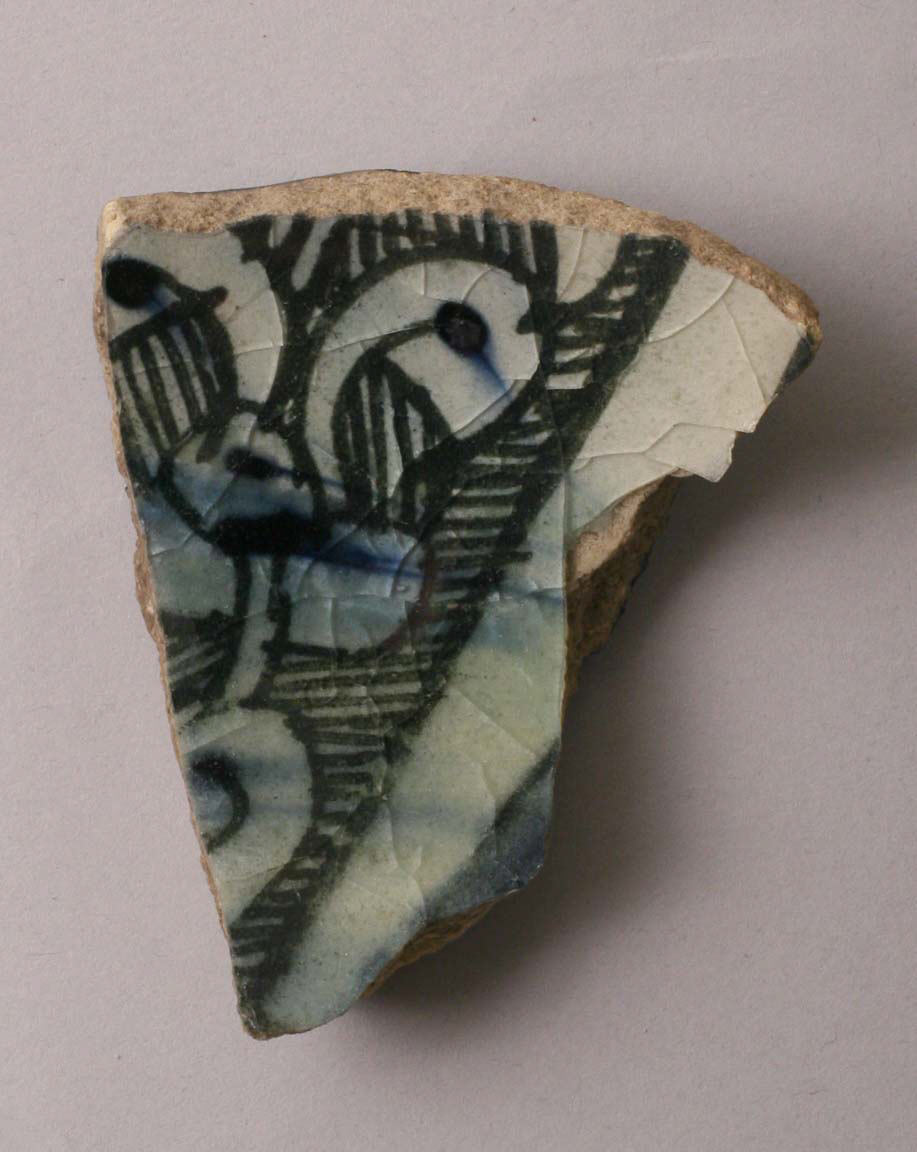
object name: fragment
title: Ceramic Fragment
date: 1301-1400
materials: glaze, stonepaste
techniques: painting, polychrome, underglaze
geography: syria